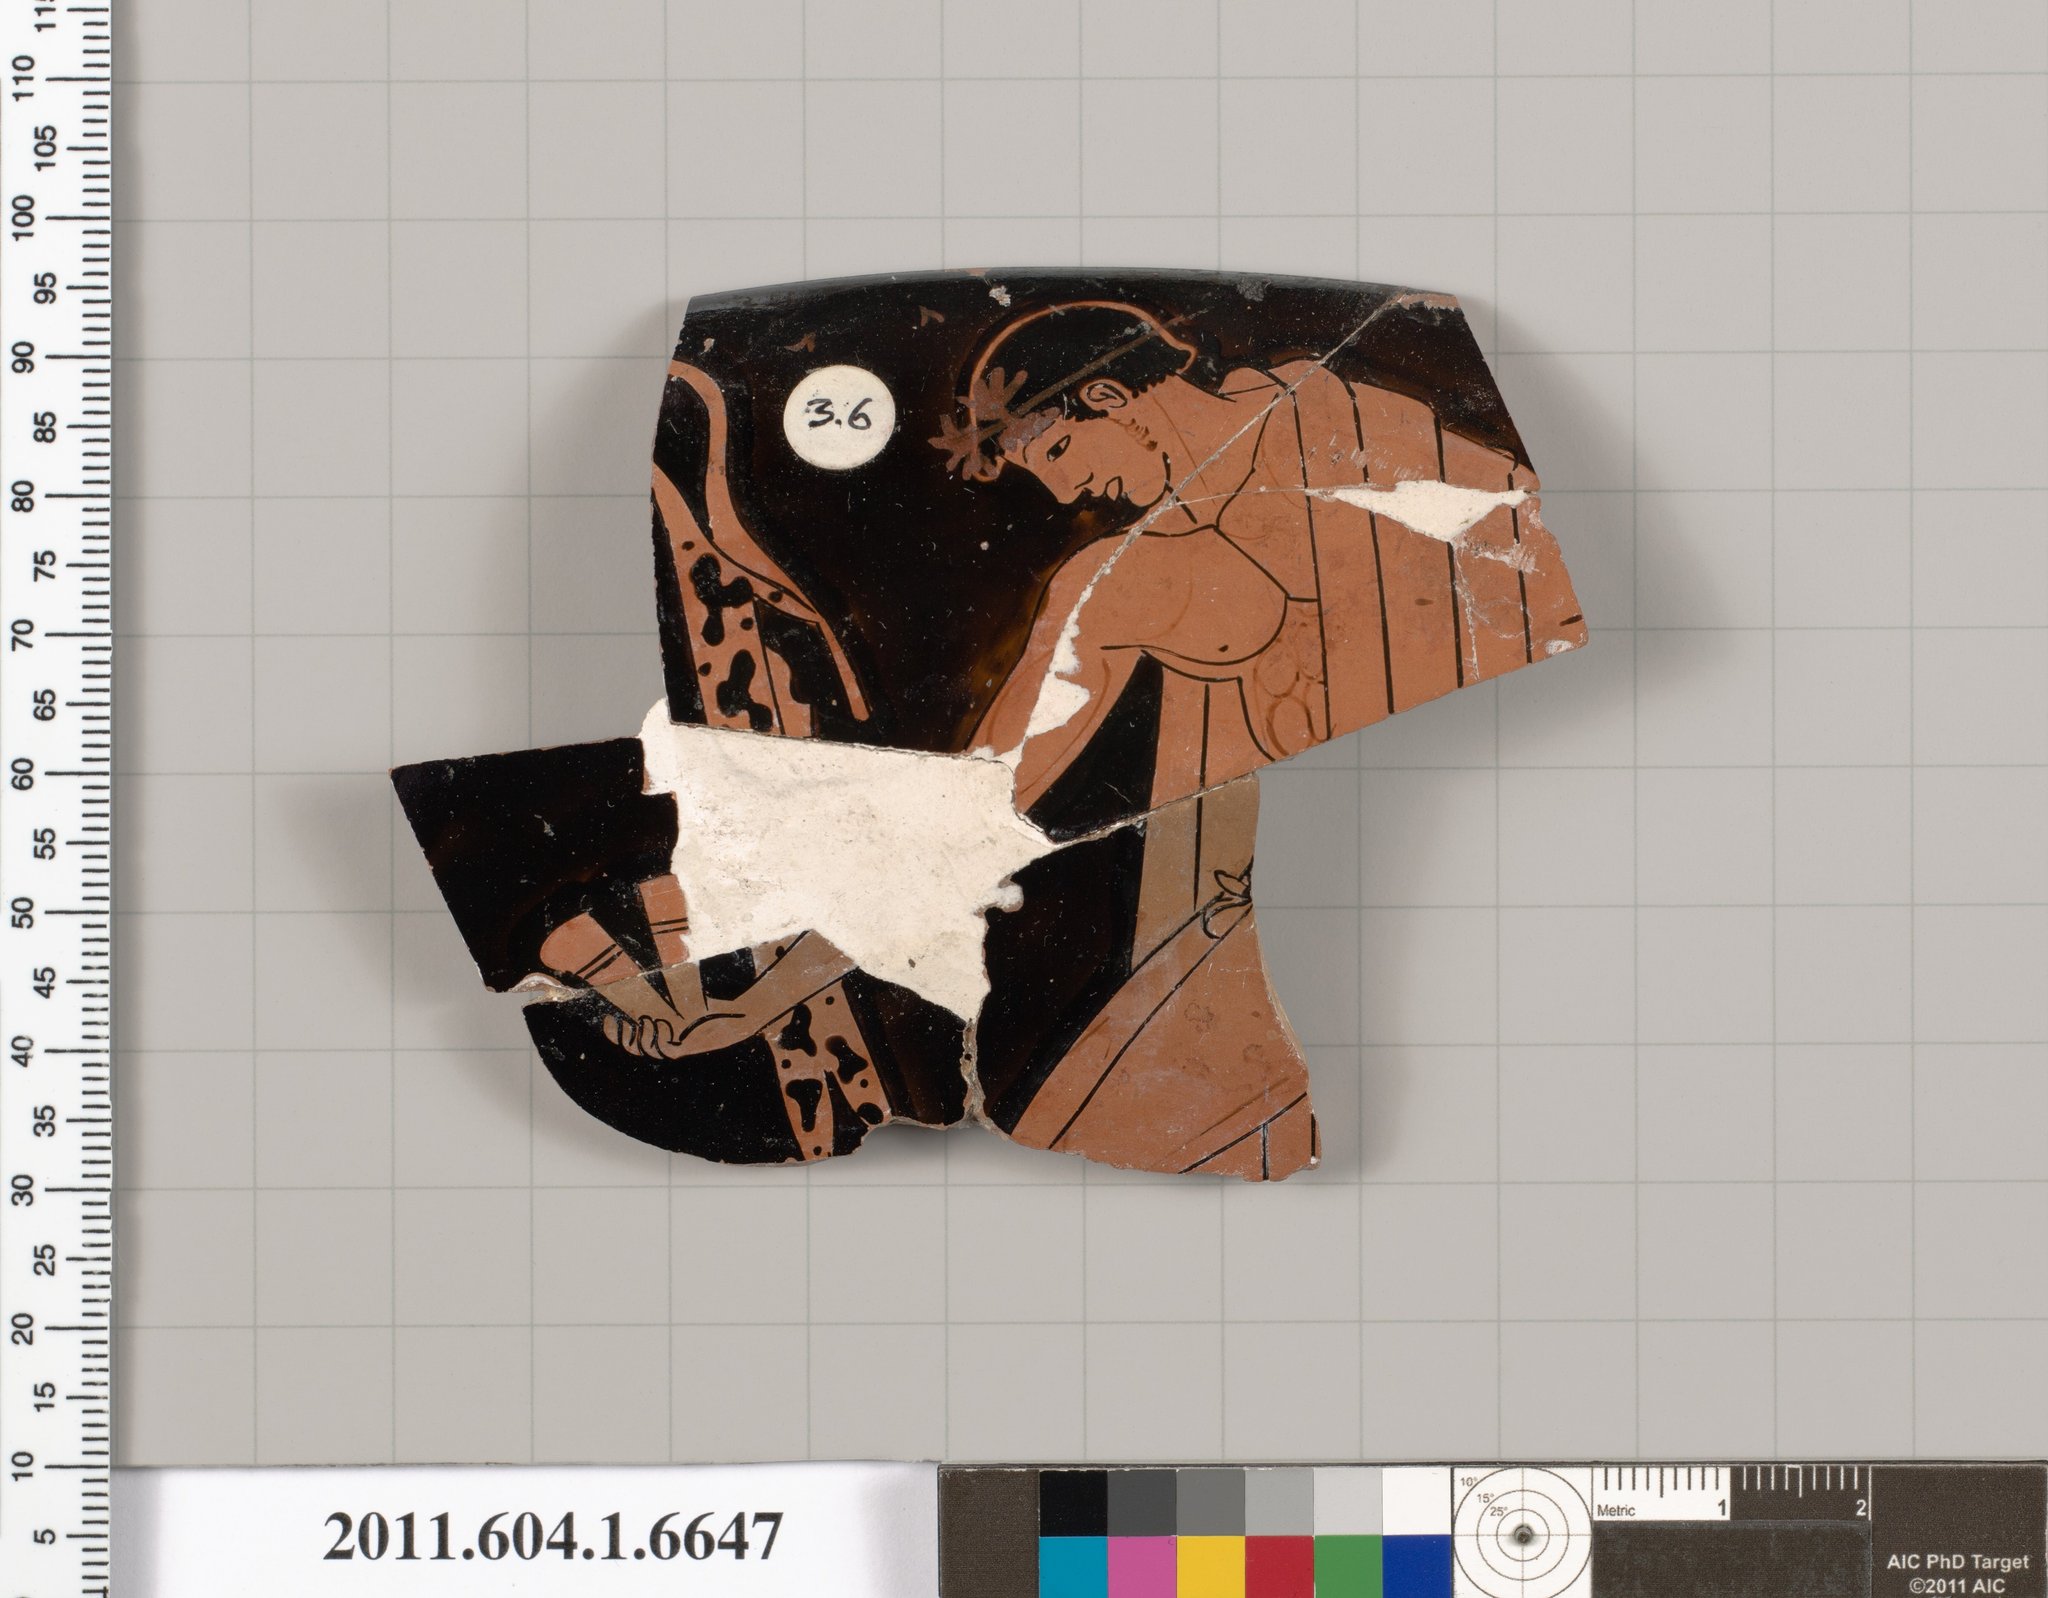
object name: kylix fragment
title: Terracotta rim fragment of a kylix (drinking cup)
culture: greek, attic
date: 490-470 BCE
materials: terracotta